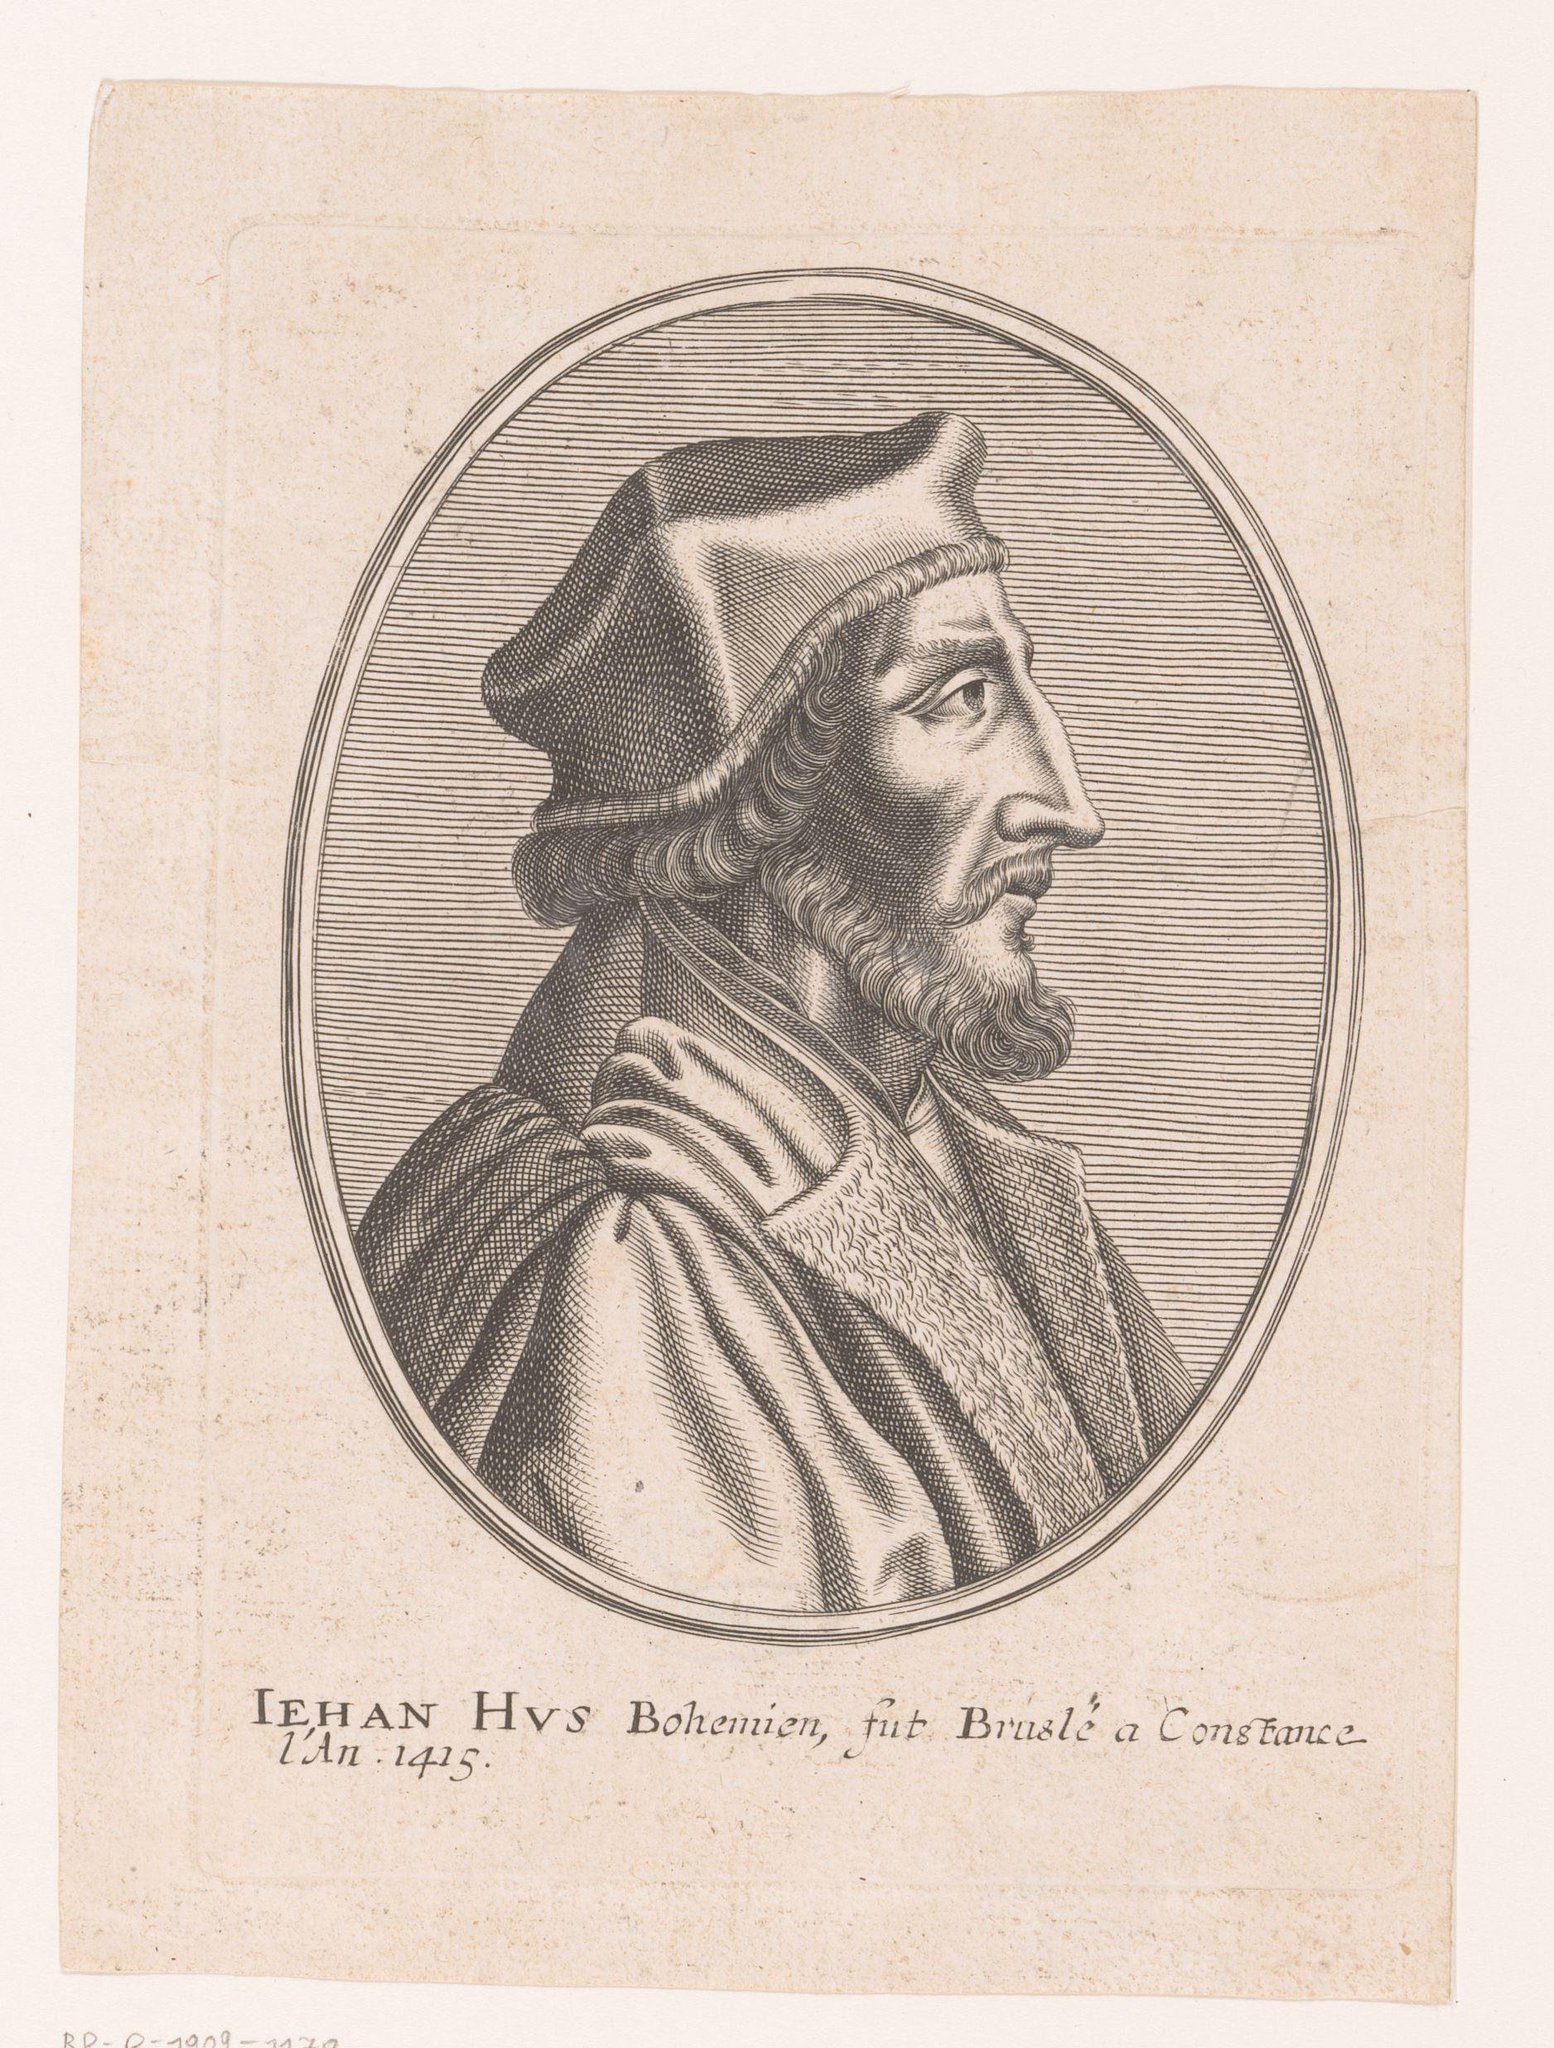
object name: print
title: Portret van Johannes Hus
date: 1610-1668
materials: paper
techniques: engraving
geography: paris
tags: historical persons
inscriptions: collector's mark: Lugt 2228